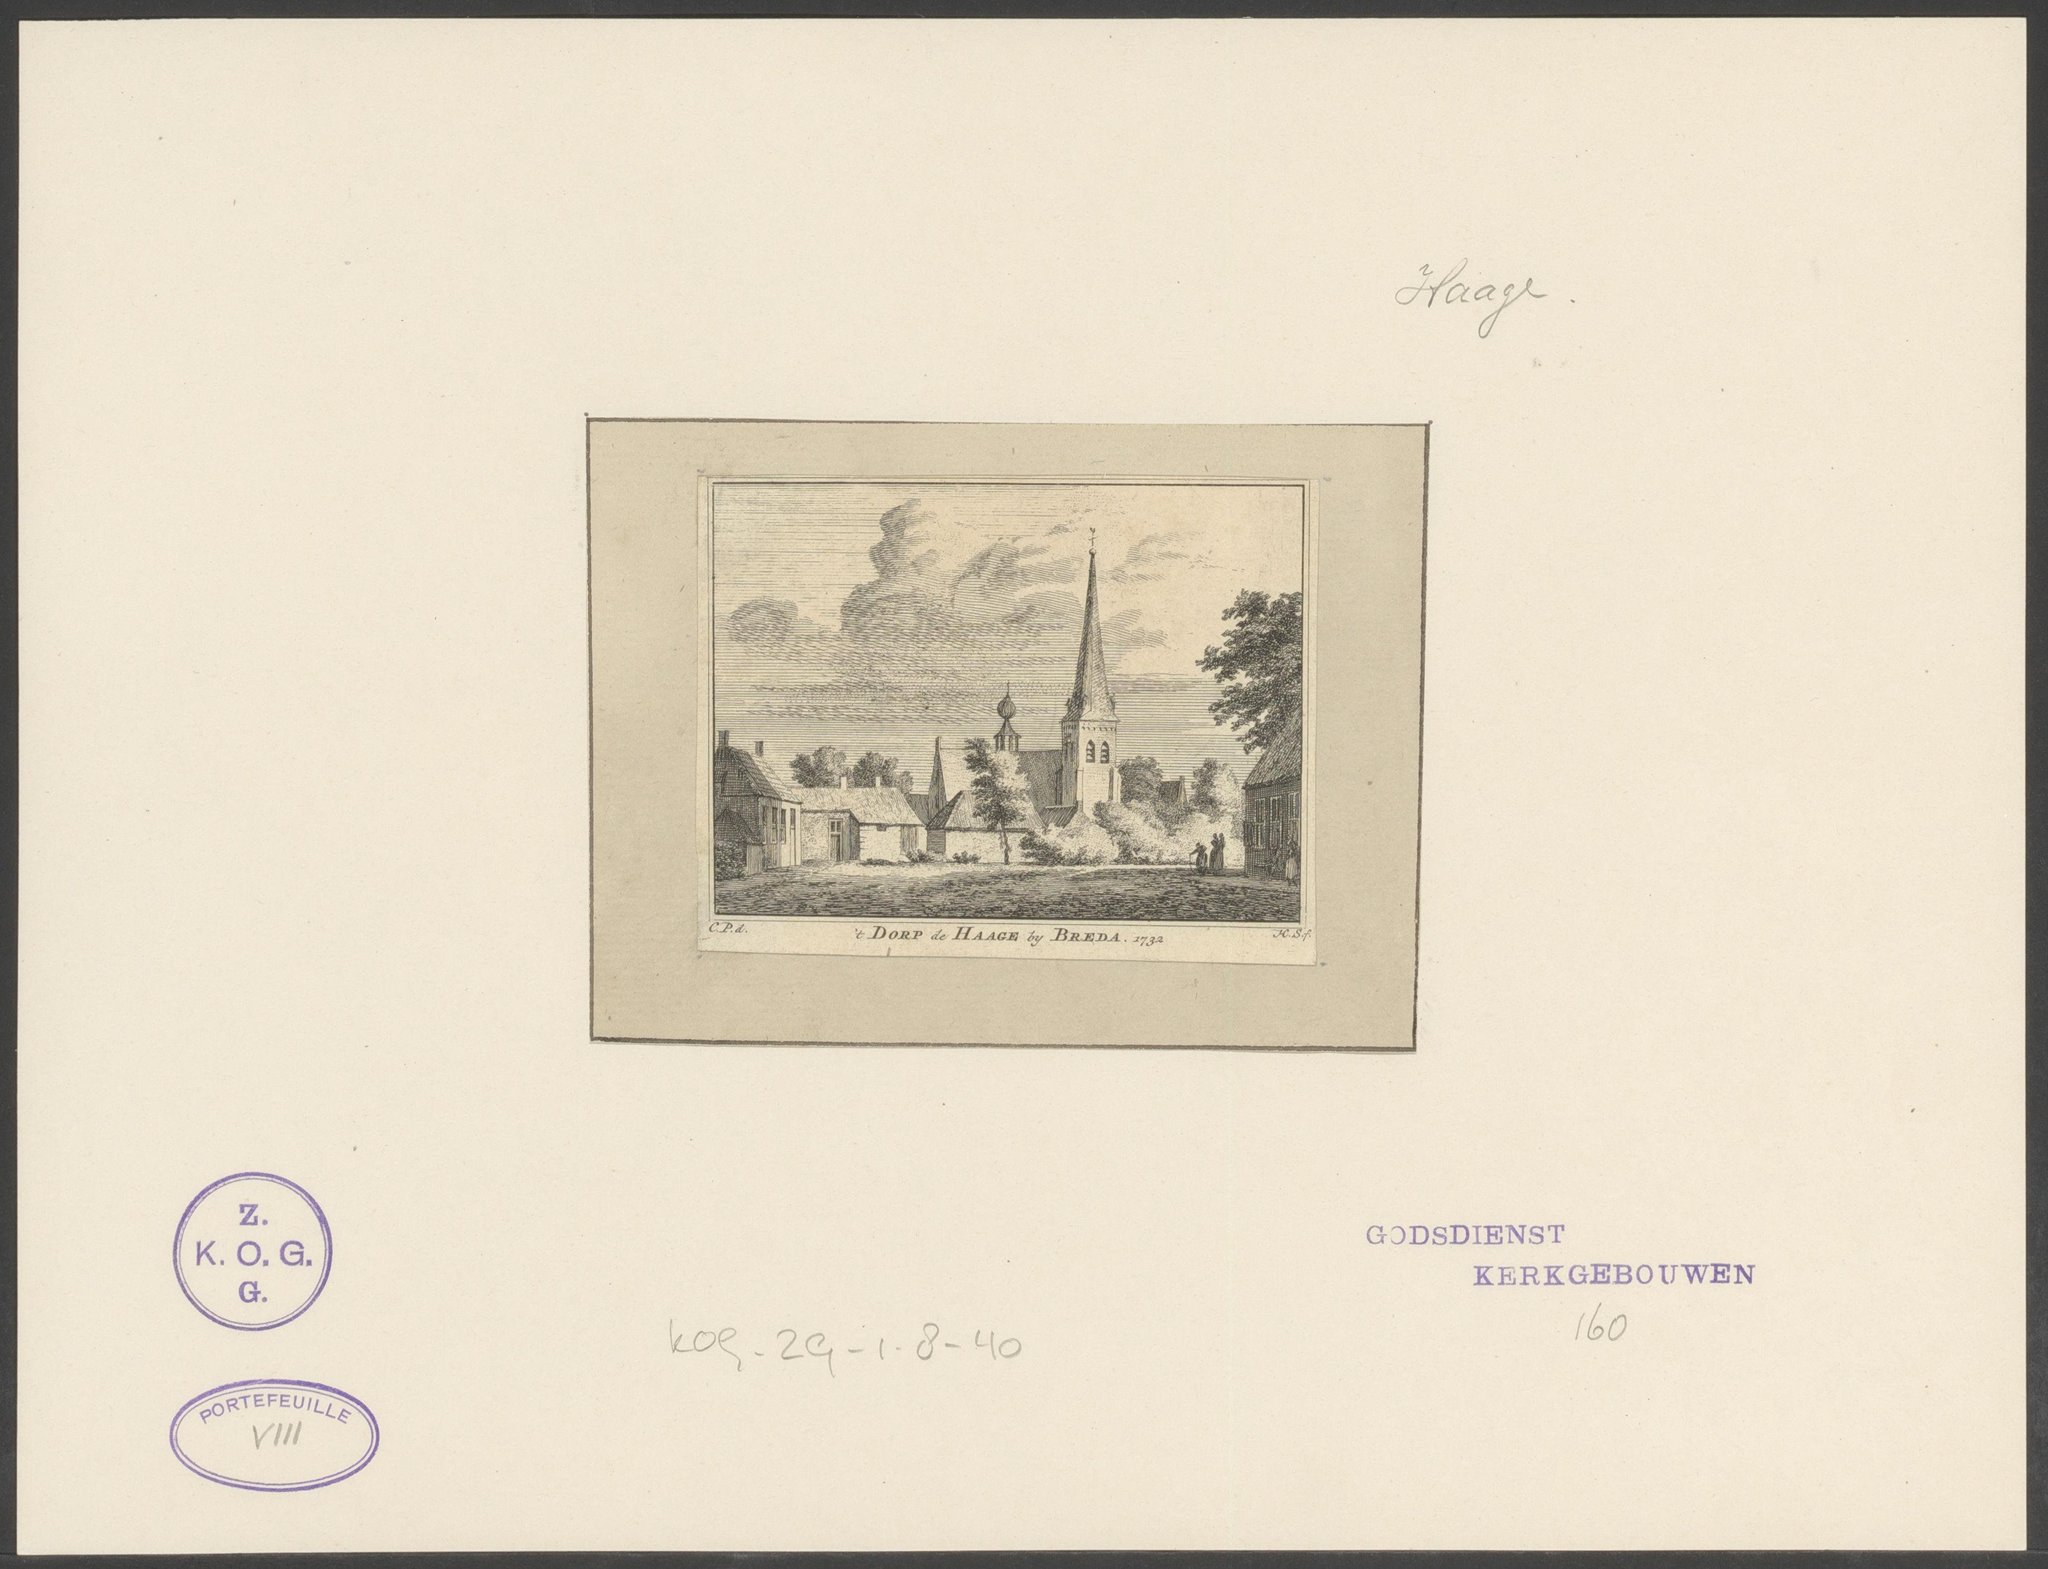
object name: print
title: 't Dorp de Haage by Breda. 1732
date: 1746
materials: paper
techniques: engraving, etching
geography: netherlands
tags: village, church (exterior)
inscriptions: collector's mark, collector's mark: Lugt 1641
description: Gezicht op het dorp Princenhage met de kerk, bij Breda in het jaar 1732. Onderwerpsrubrieken binnen de Atlas Zeden en Gewoonten: Kerk en kerkwezen & Armwezen en liefdadige instellingen; Kerkgebouwen elders. F-L.